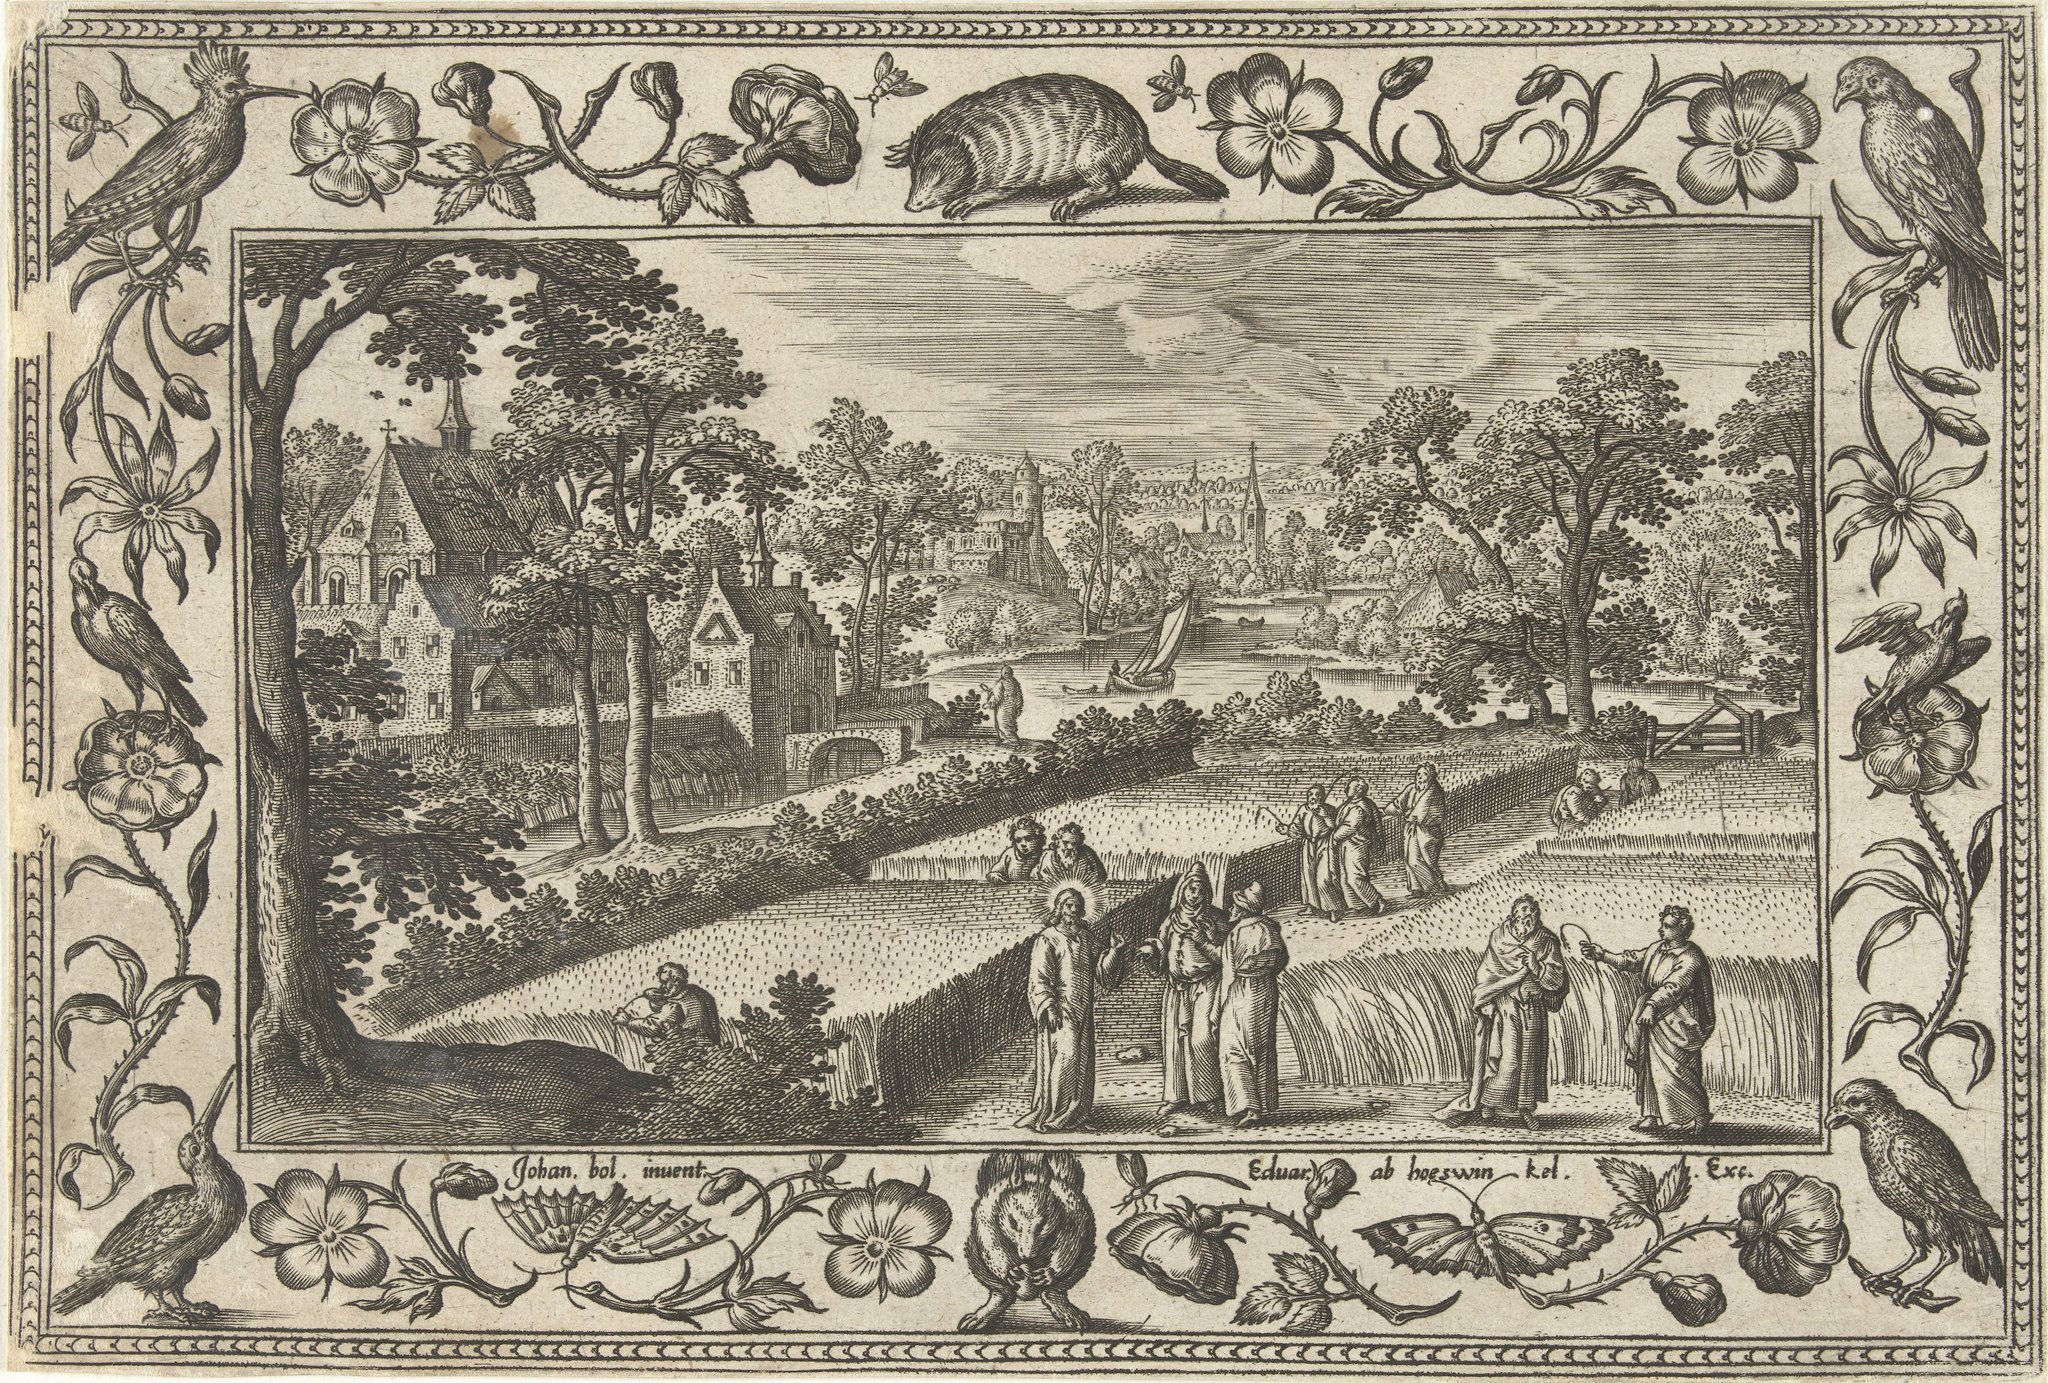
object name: print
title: Plukken van koren op de sabbat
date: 1582-1586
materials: paper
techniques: engraving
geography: antwerp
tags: ornamental birds, discussion with pharisees about the plucking of corn, disciples pluck ears of corn on sabbath, and eat (matthew 12:1-8; mark 2:23-28; luke 6:1-5), cultivated land, rodents: squirrel (+ ornamental variants of animals), other mammals: mole (+ ornamental variants of animals), flowers ~ ornament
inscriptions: collector's mark: Lugt 2228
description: Landschap met een korenveld. Centraalt vertelt Christus aan de Farizeeën dat zijn apostelen de sabbat niet ontwijden als zij zich met korenaren tegoeddoen uit het veld om hun honger te stillen. Op de achtergrond plukken de apostelen korenaren. De prent heeft een ornamentele lijst met bloemen en dieren. Hij maakt deel uit van een vierentwintigdelige serie van landschappen met Bijbelse, mythologische scènes en jachttaferelen.